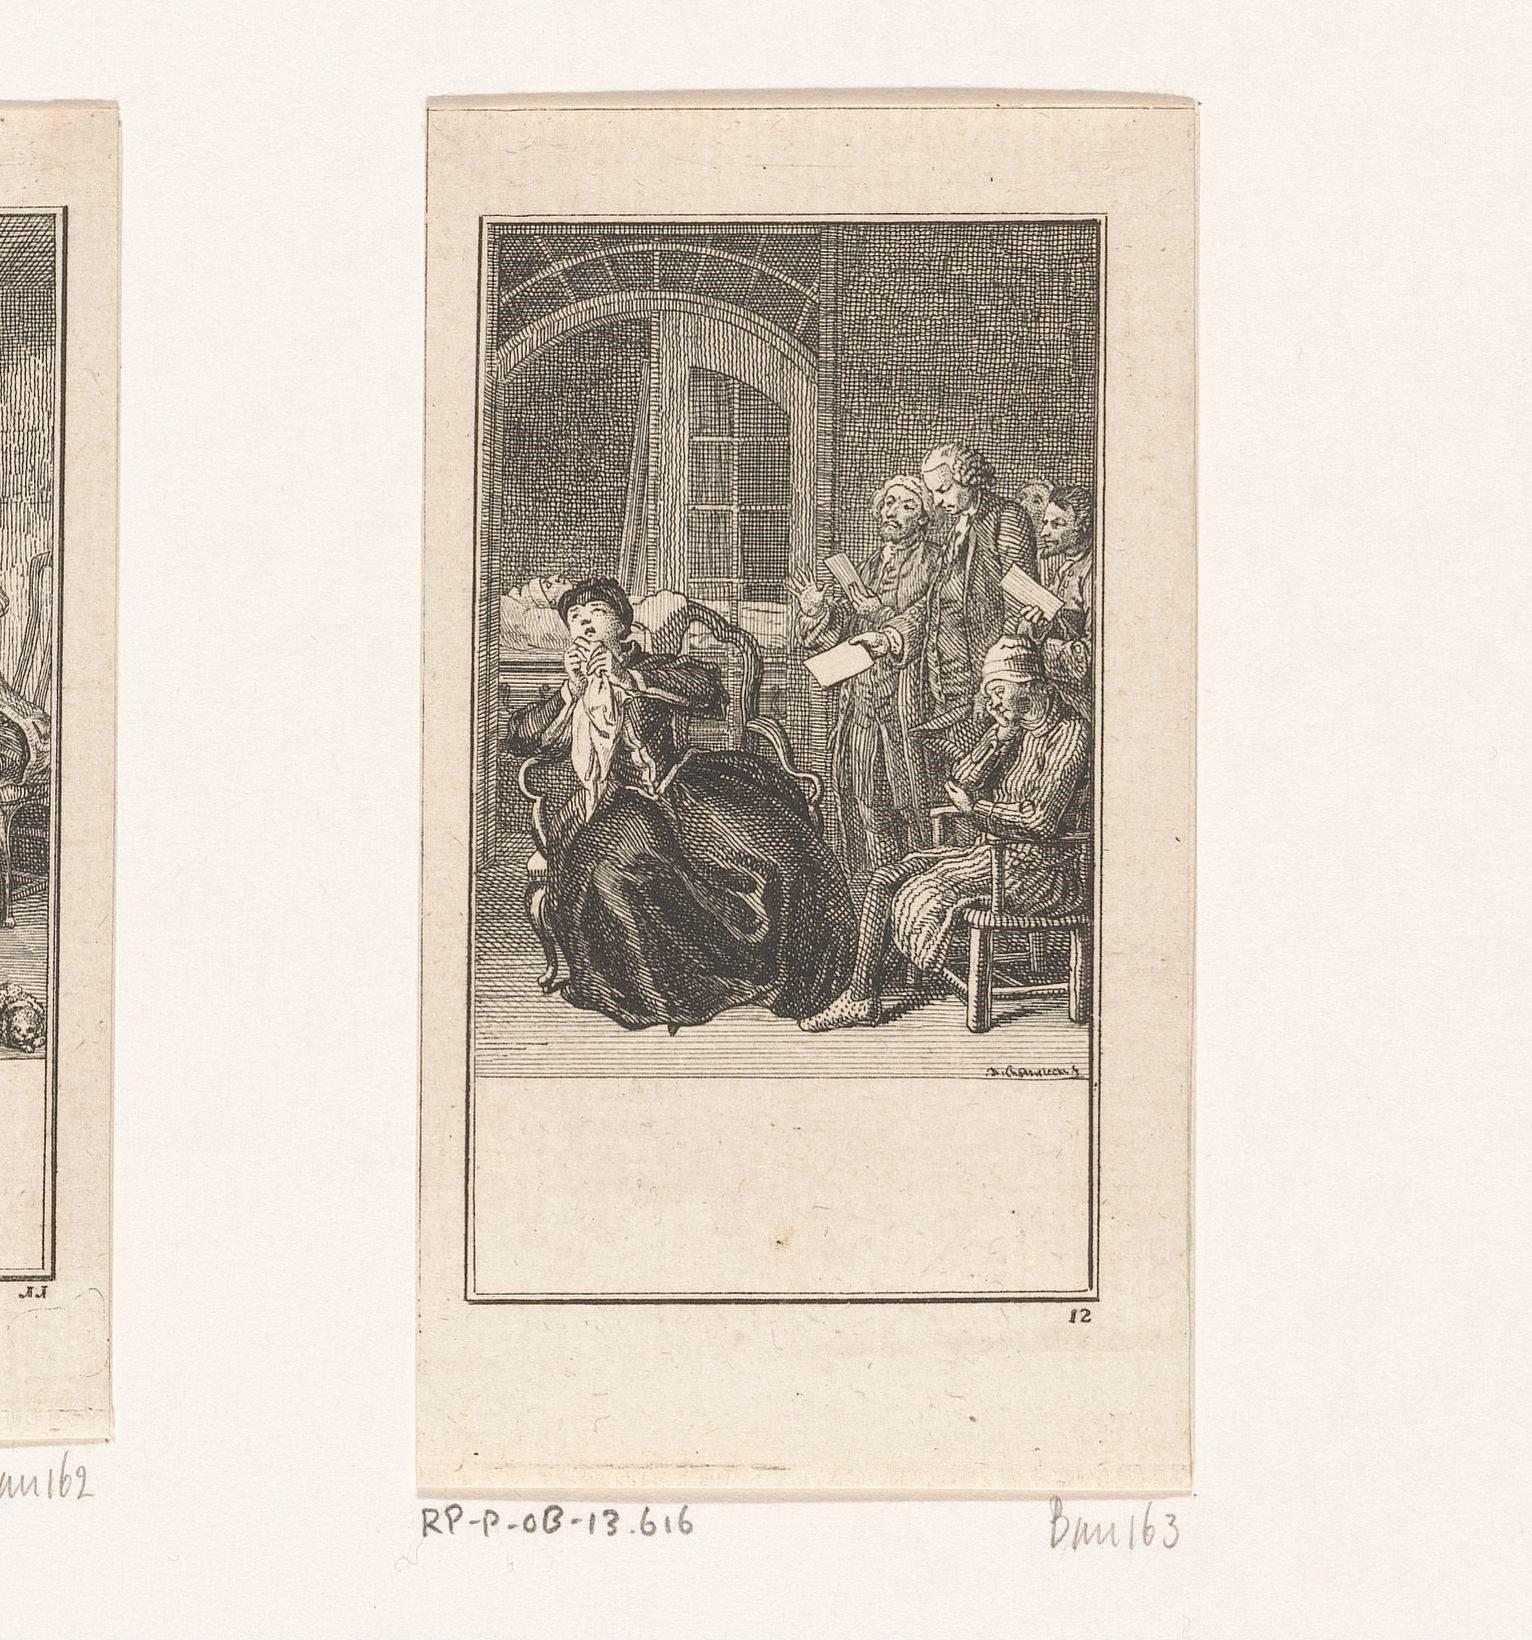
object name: print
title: Einde van het welgenoten leven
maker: daniel nikolaus chodowiecki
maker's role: draughtsman, print maker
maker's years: 1726-1801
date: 1773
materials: paper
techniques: etching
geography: berlin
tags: deathbed, weeping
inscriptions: collector's mark: Lugt 2228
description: Twaalfde prent uit een serie met 12 scènes uit 'een liederlijk leven'. De twaalf scènes werden samen op een plaat geëtst. De tweede staat van deze serie is gebruikt als illustratie in: 'Berliner genealogischen Calender auf das Jahr 1774'. Aan de hand van deze prentserie schreef Johann Christian Ludwig Haken (1767-1835) zijn briefroman 'Der Lüderliche'.